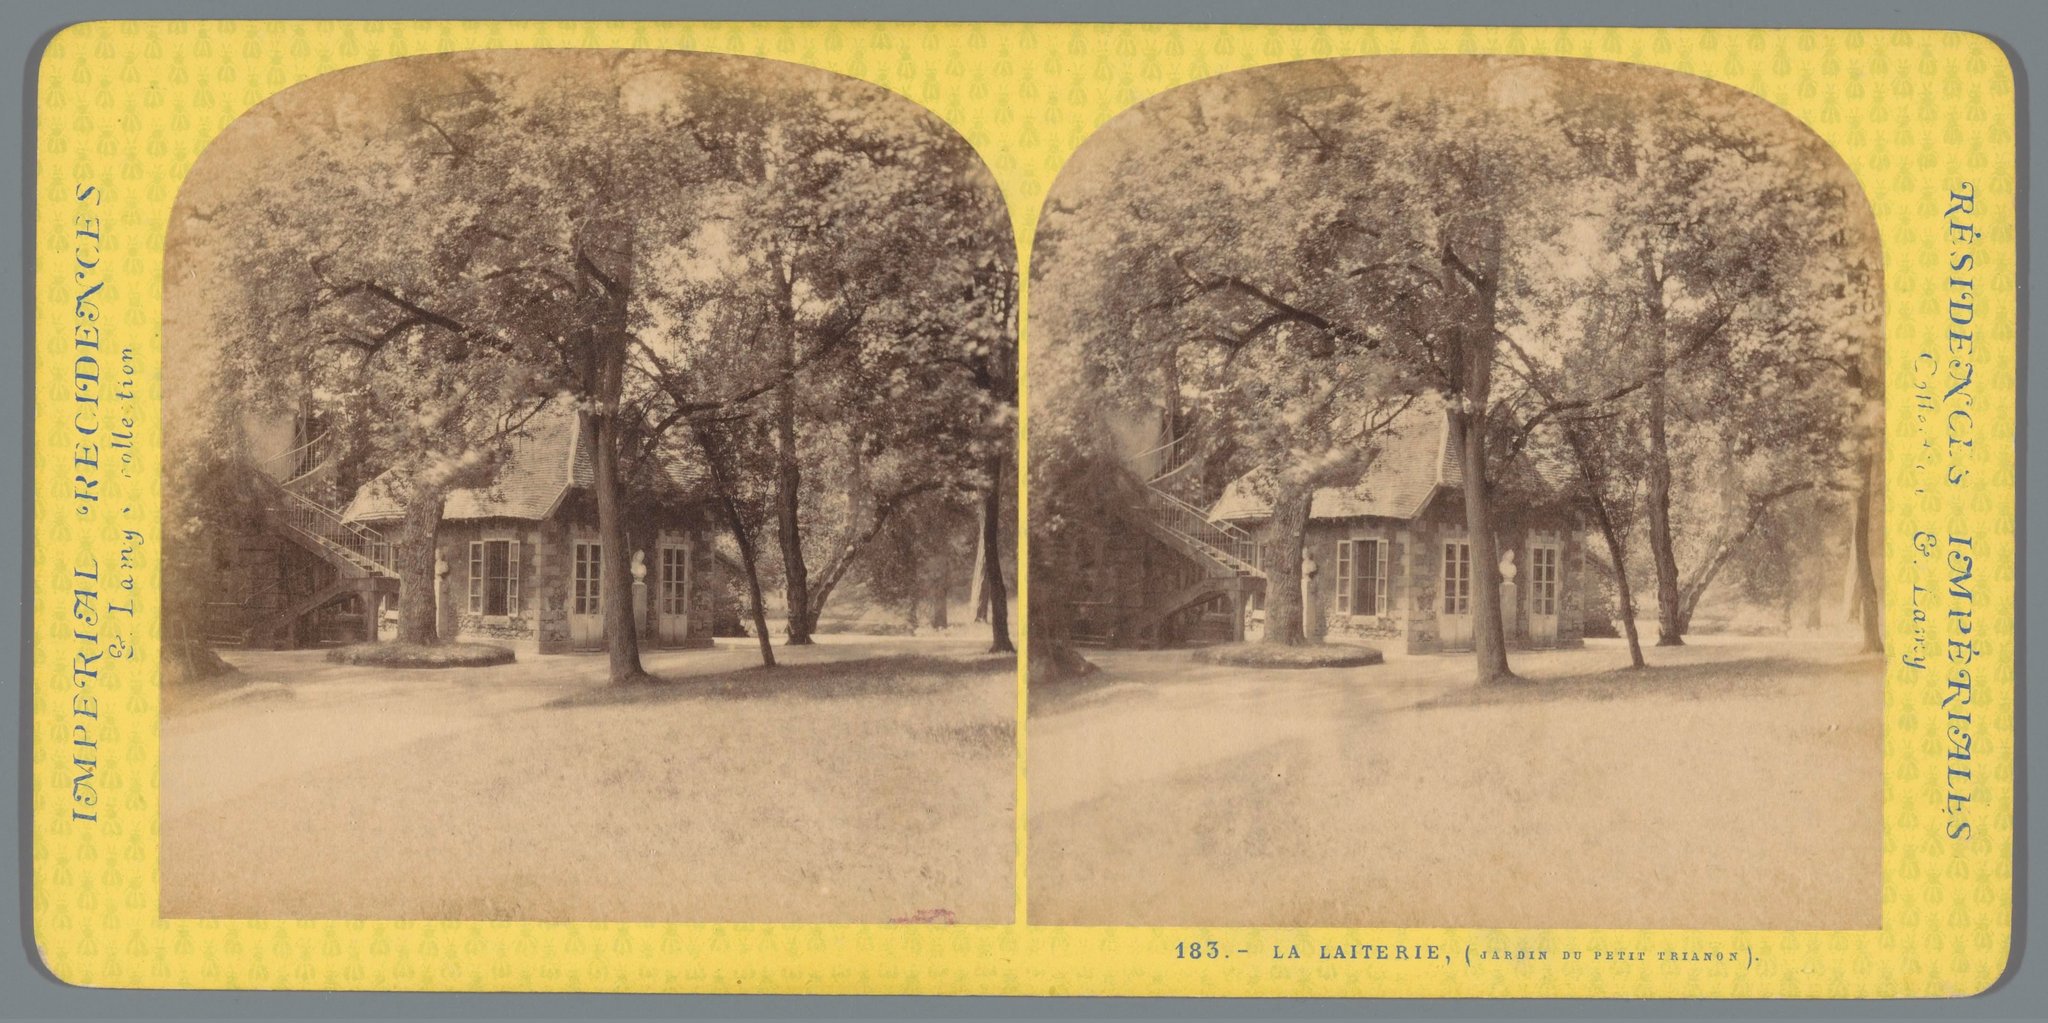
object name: stereograph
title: La Laiterie, (Jardin du Petit Trianon)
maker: ernest eléonor pierre lamy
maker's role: publisher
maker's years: 1828-1900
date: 1860-1880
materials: cardboard, photographic support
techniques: albumen print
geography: le hameau de la reine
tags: garden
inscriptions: inscription: ‘E. Lamy's collection’, number: ‘183.’